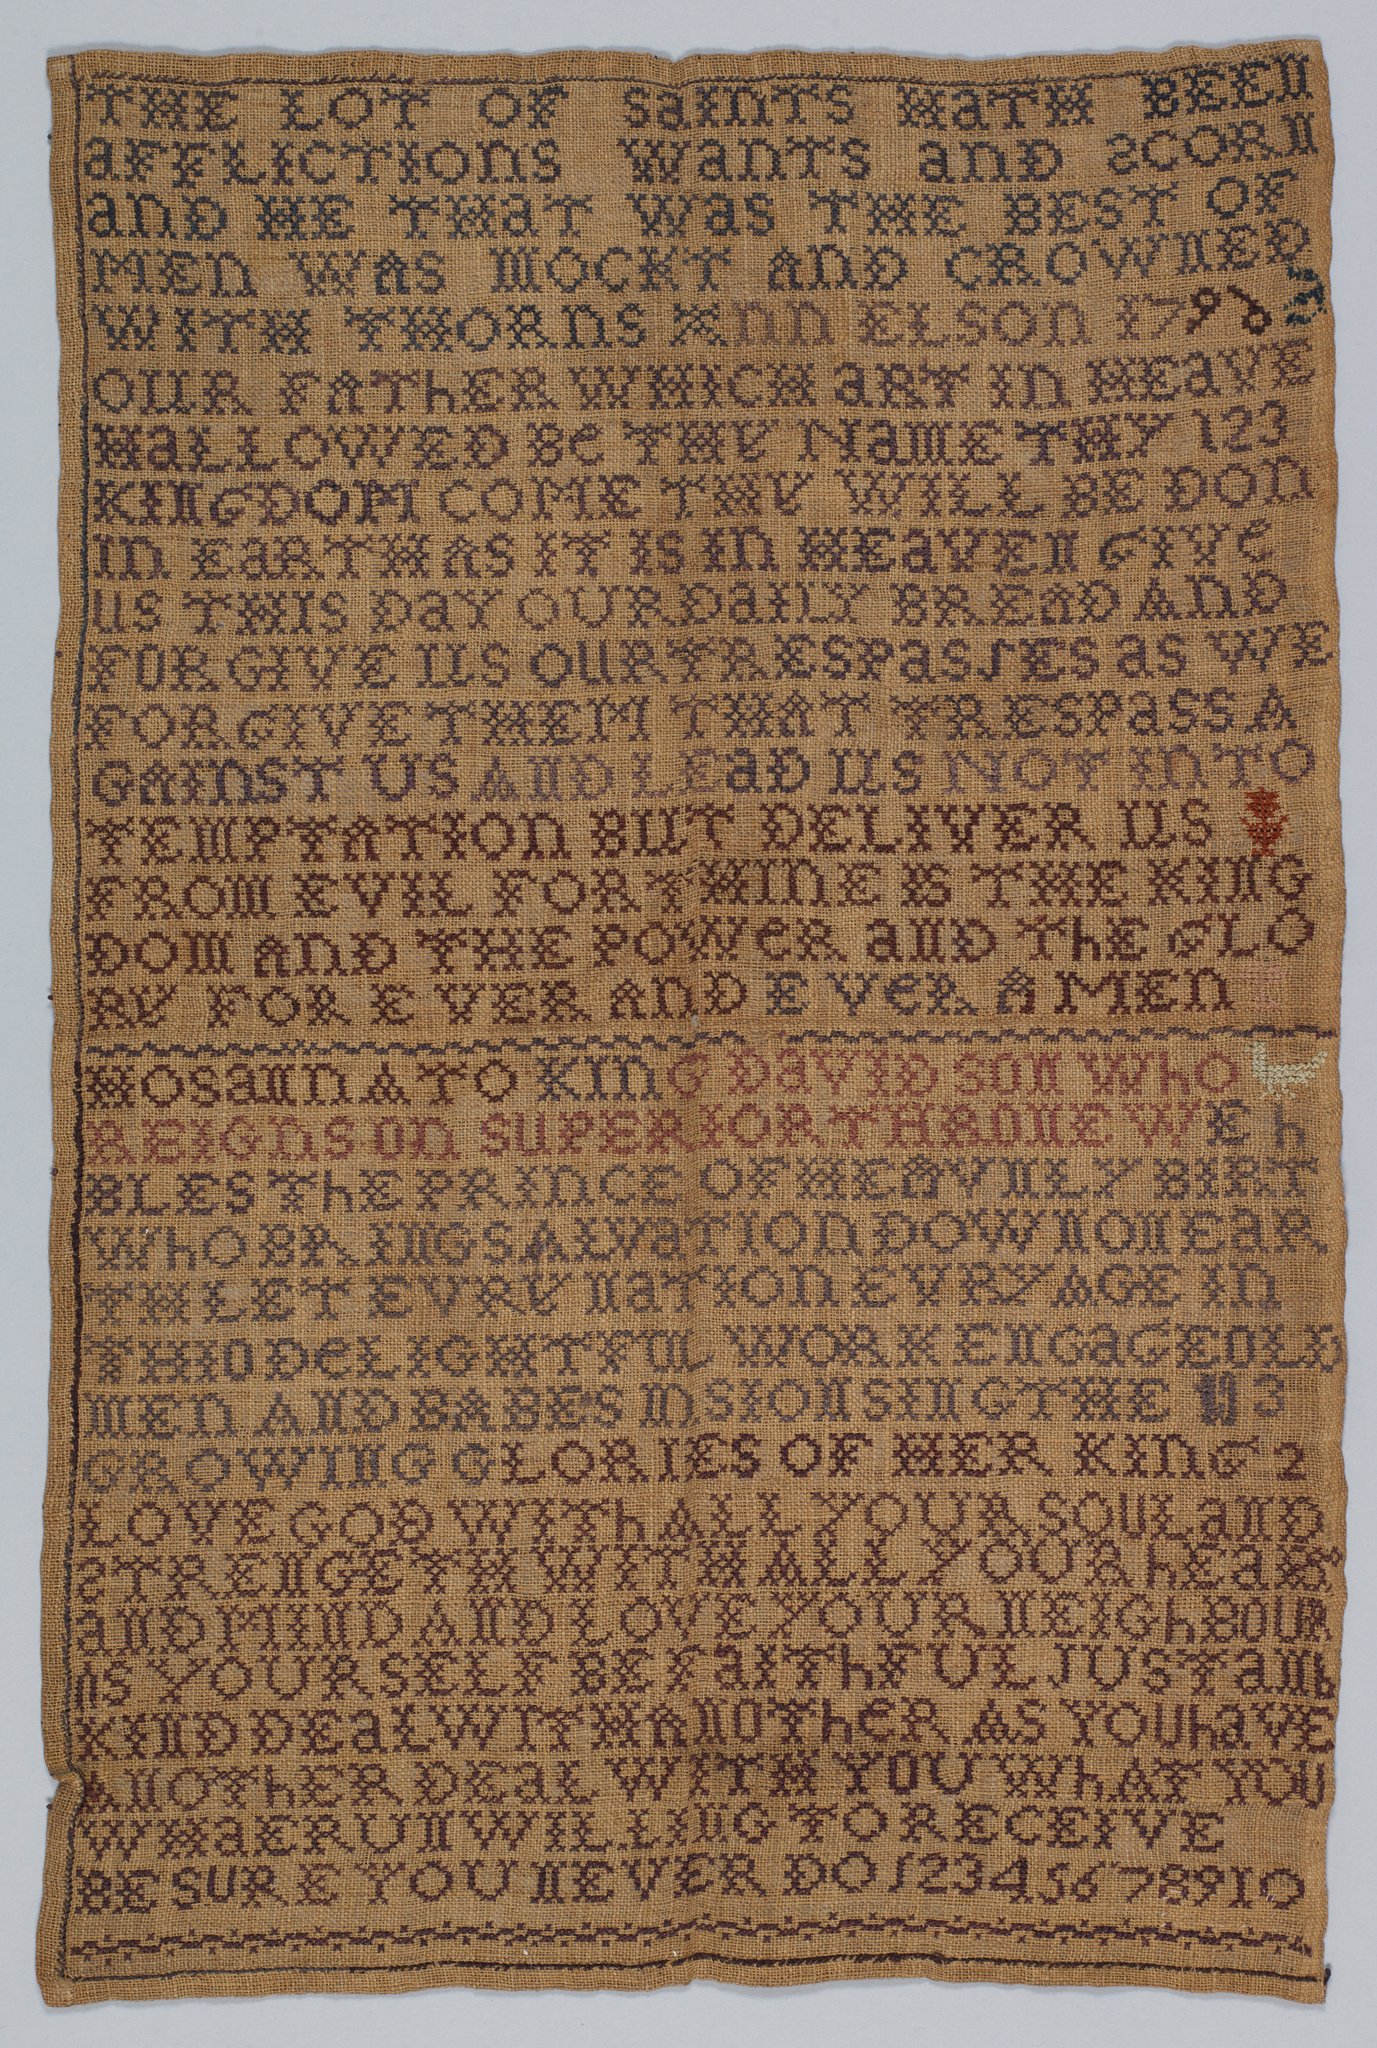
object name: sampler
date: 1796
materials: linen, silk